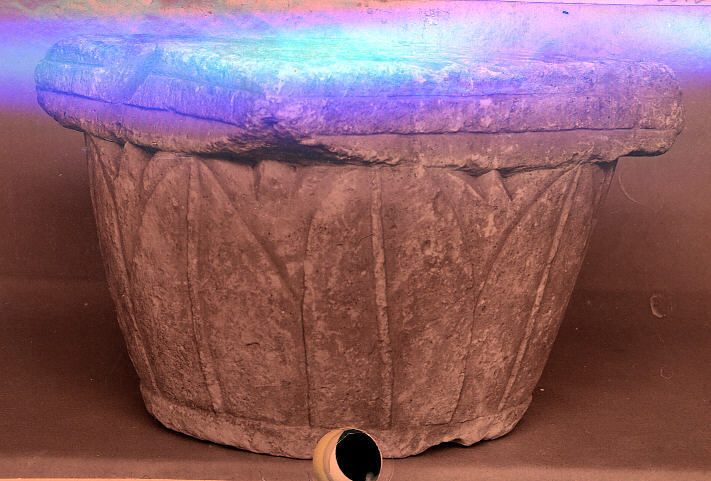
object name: capital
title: Capital with Palm Leaves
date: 501-700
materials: limestone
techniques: carving, relief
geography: egypt